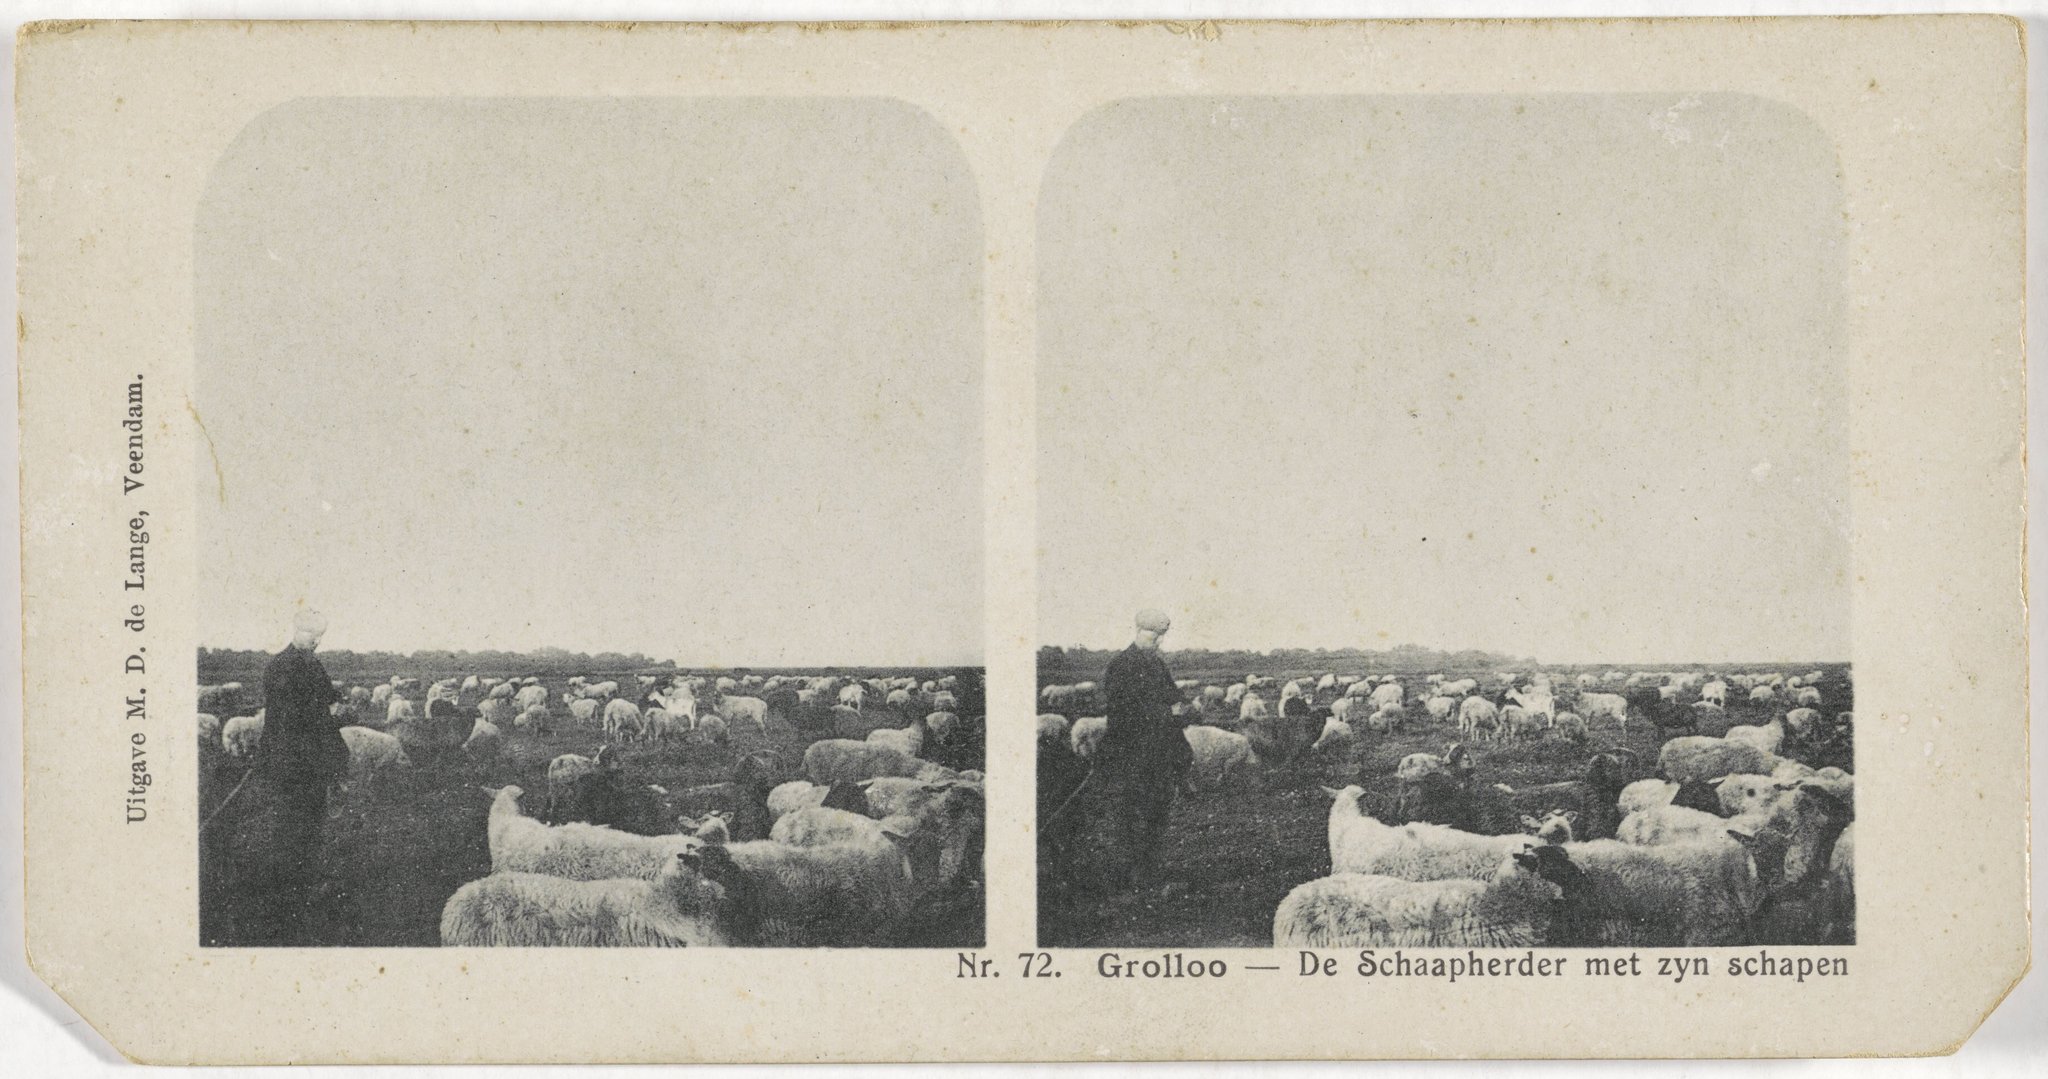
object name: stereograph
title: Herder met zijn kudde schapen in Grolloo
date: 1900-1911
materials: paper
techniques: photograph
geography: veendam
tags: herding, herdsman, herdswoman, shepherd, shepherdess, cowherd, etc., sheep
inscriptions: number: ‘Nr. 72.’